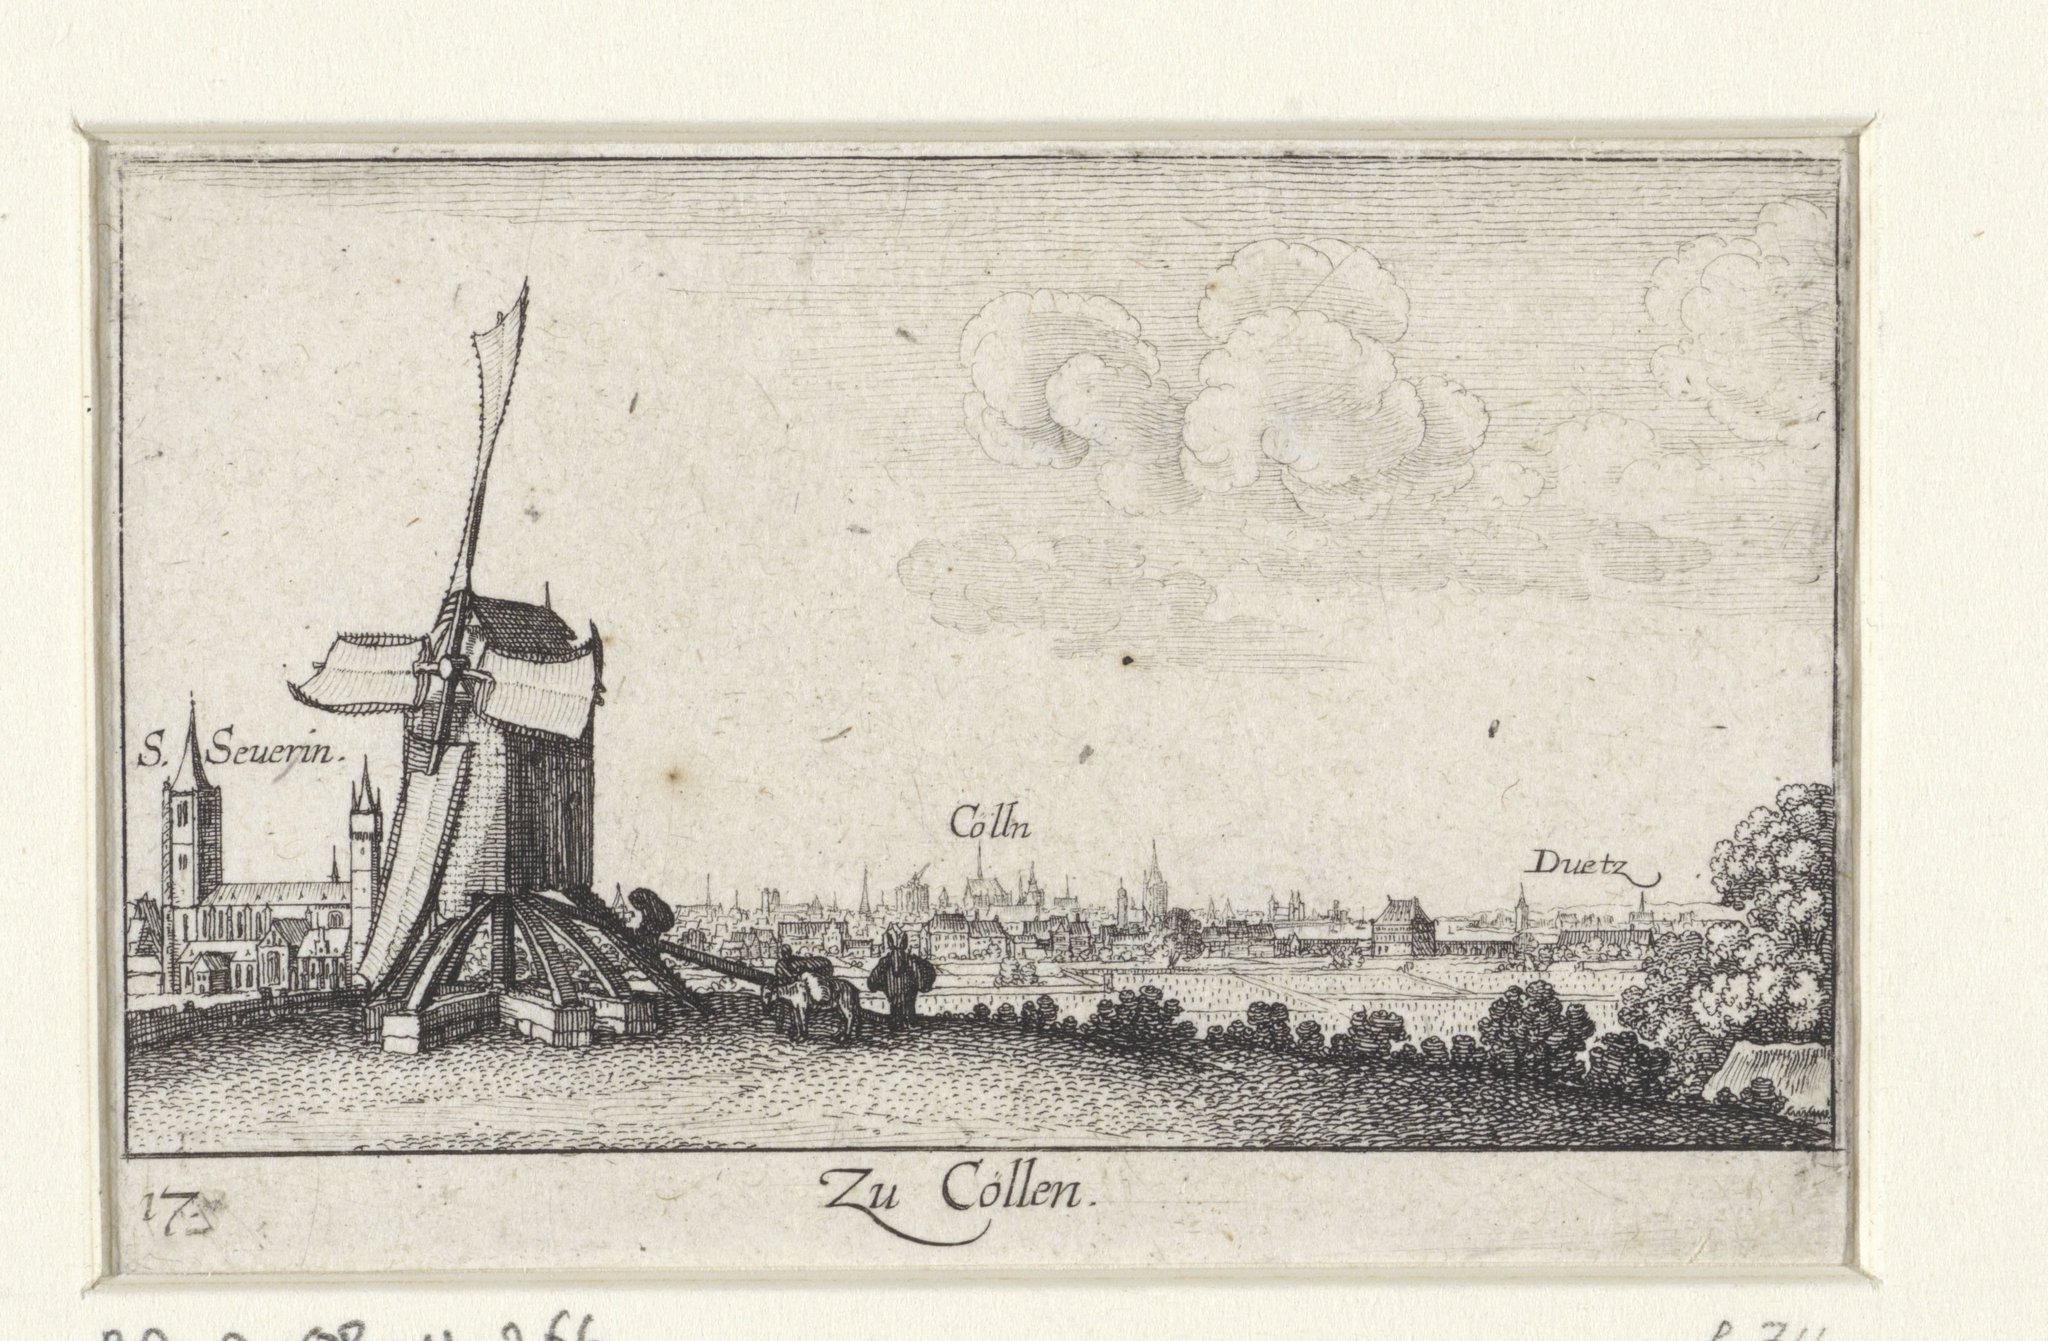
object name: print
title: Amoenissimae Aliquot Locorum In Diversis Provincijs iacentiu Effigies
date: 1635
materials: paper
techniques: etching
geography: cologne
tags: city-view, and landscape with man-made constructions, cologne